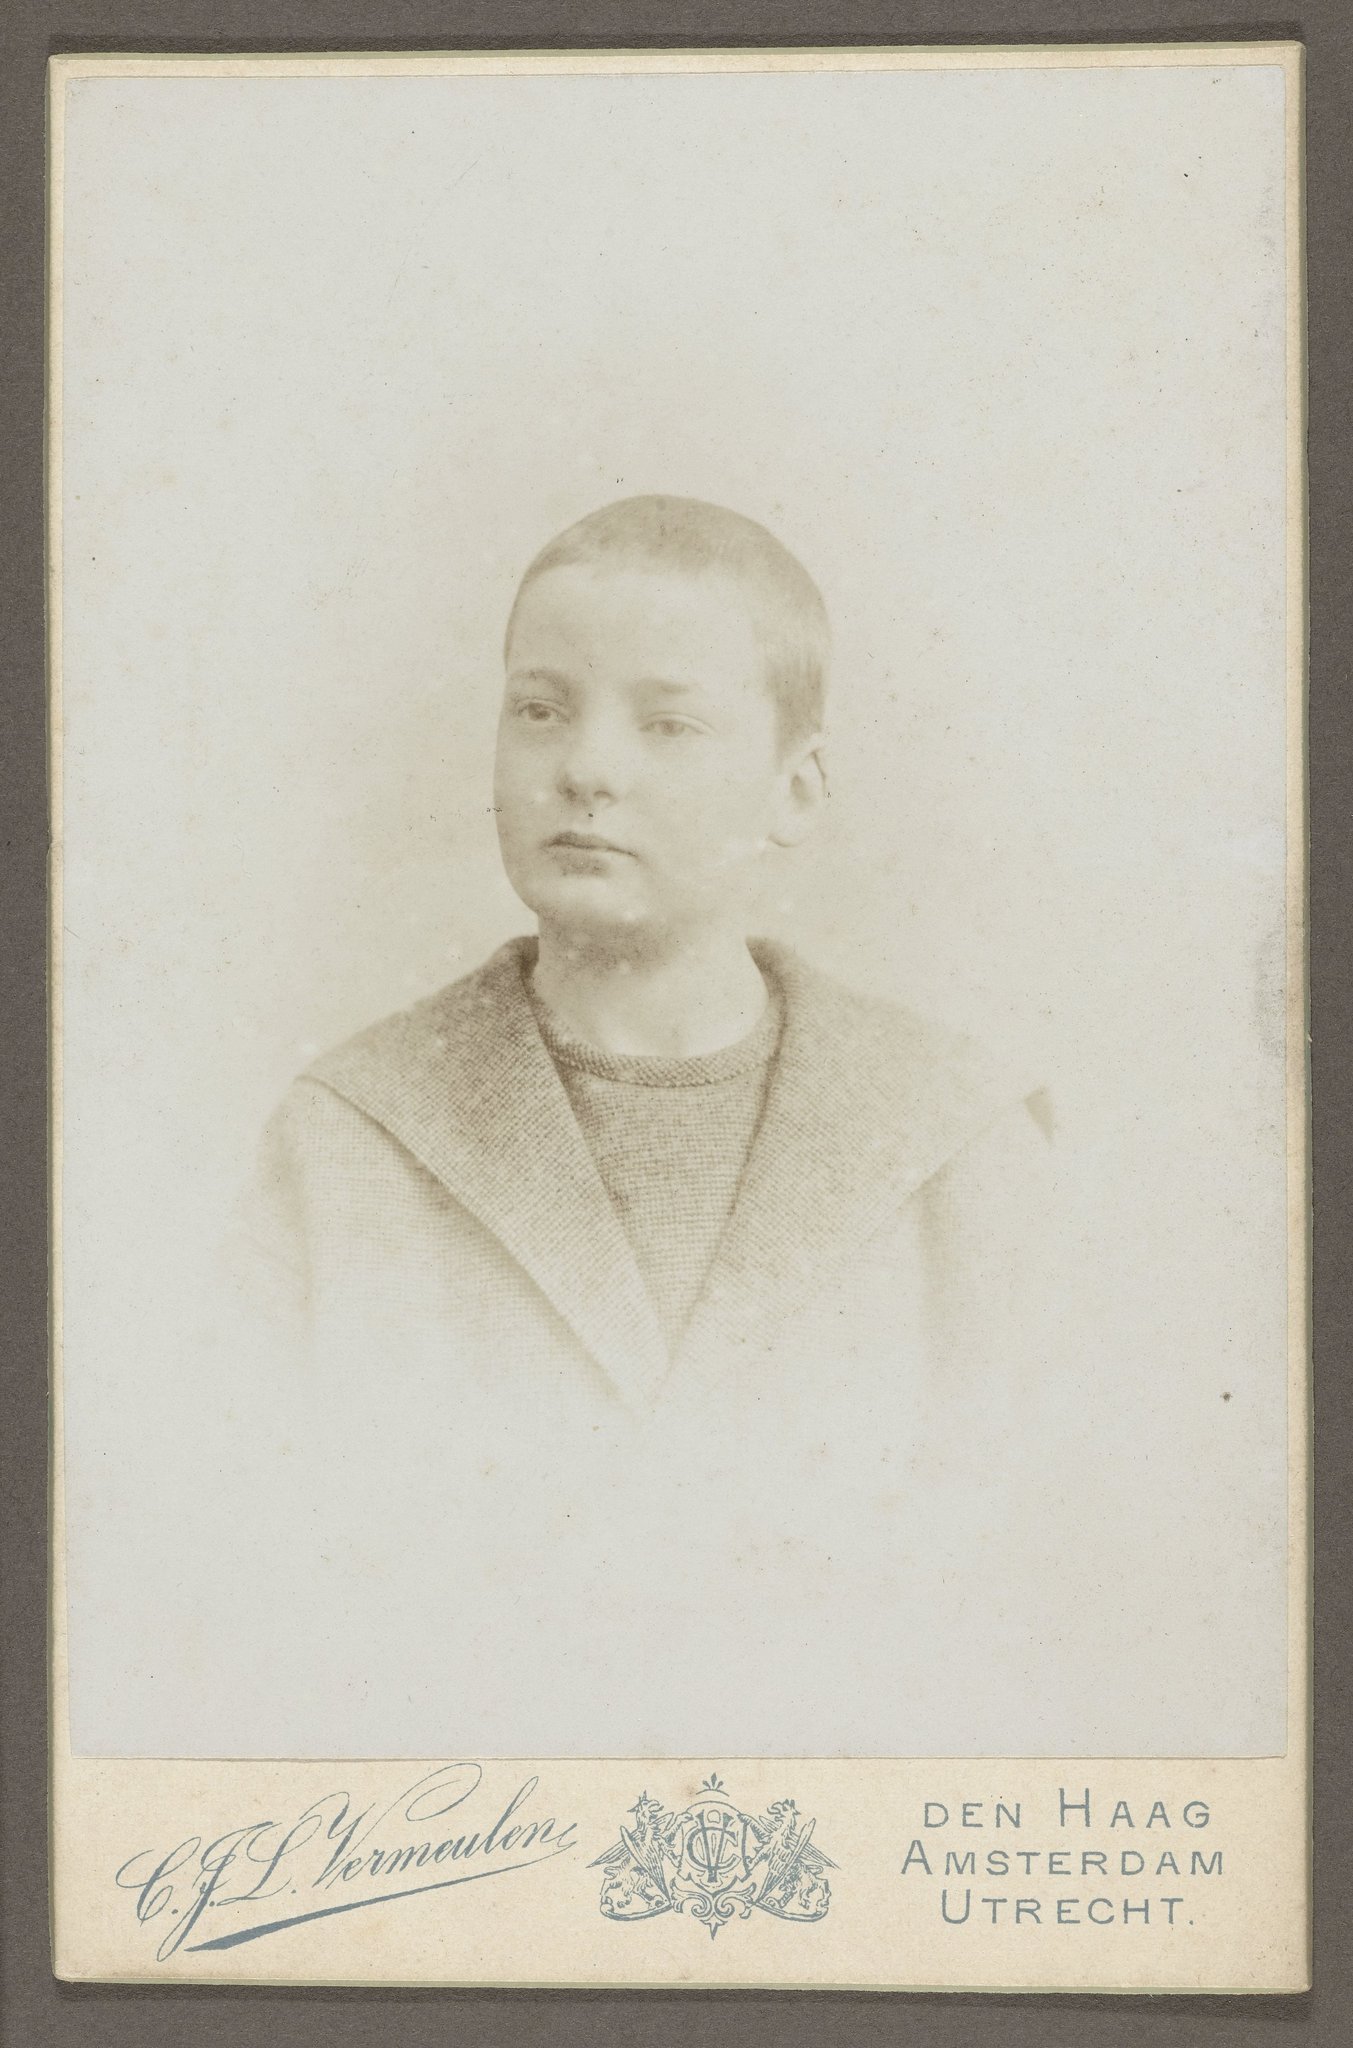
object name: cabinet photograph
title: Portret van Bram Vermeulen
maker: cornelis johannes lodewicus vermeulen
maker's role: fotograaf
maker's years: 1861-1936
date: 1888-1896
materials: paper, cardboard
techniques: collodion silver print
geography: amsterdam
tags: boy (child between toddler and youth), historical persons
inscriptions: inscription: ‘Bram’